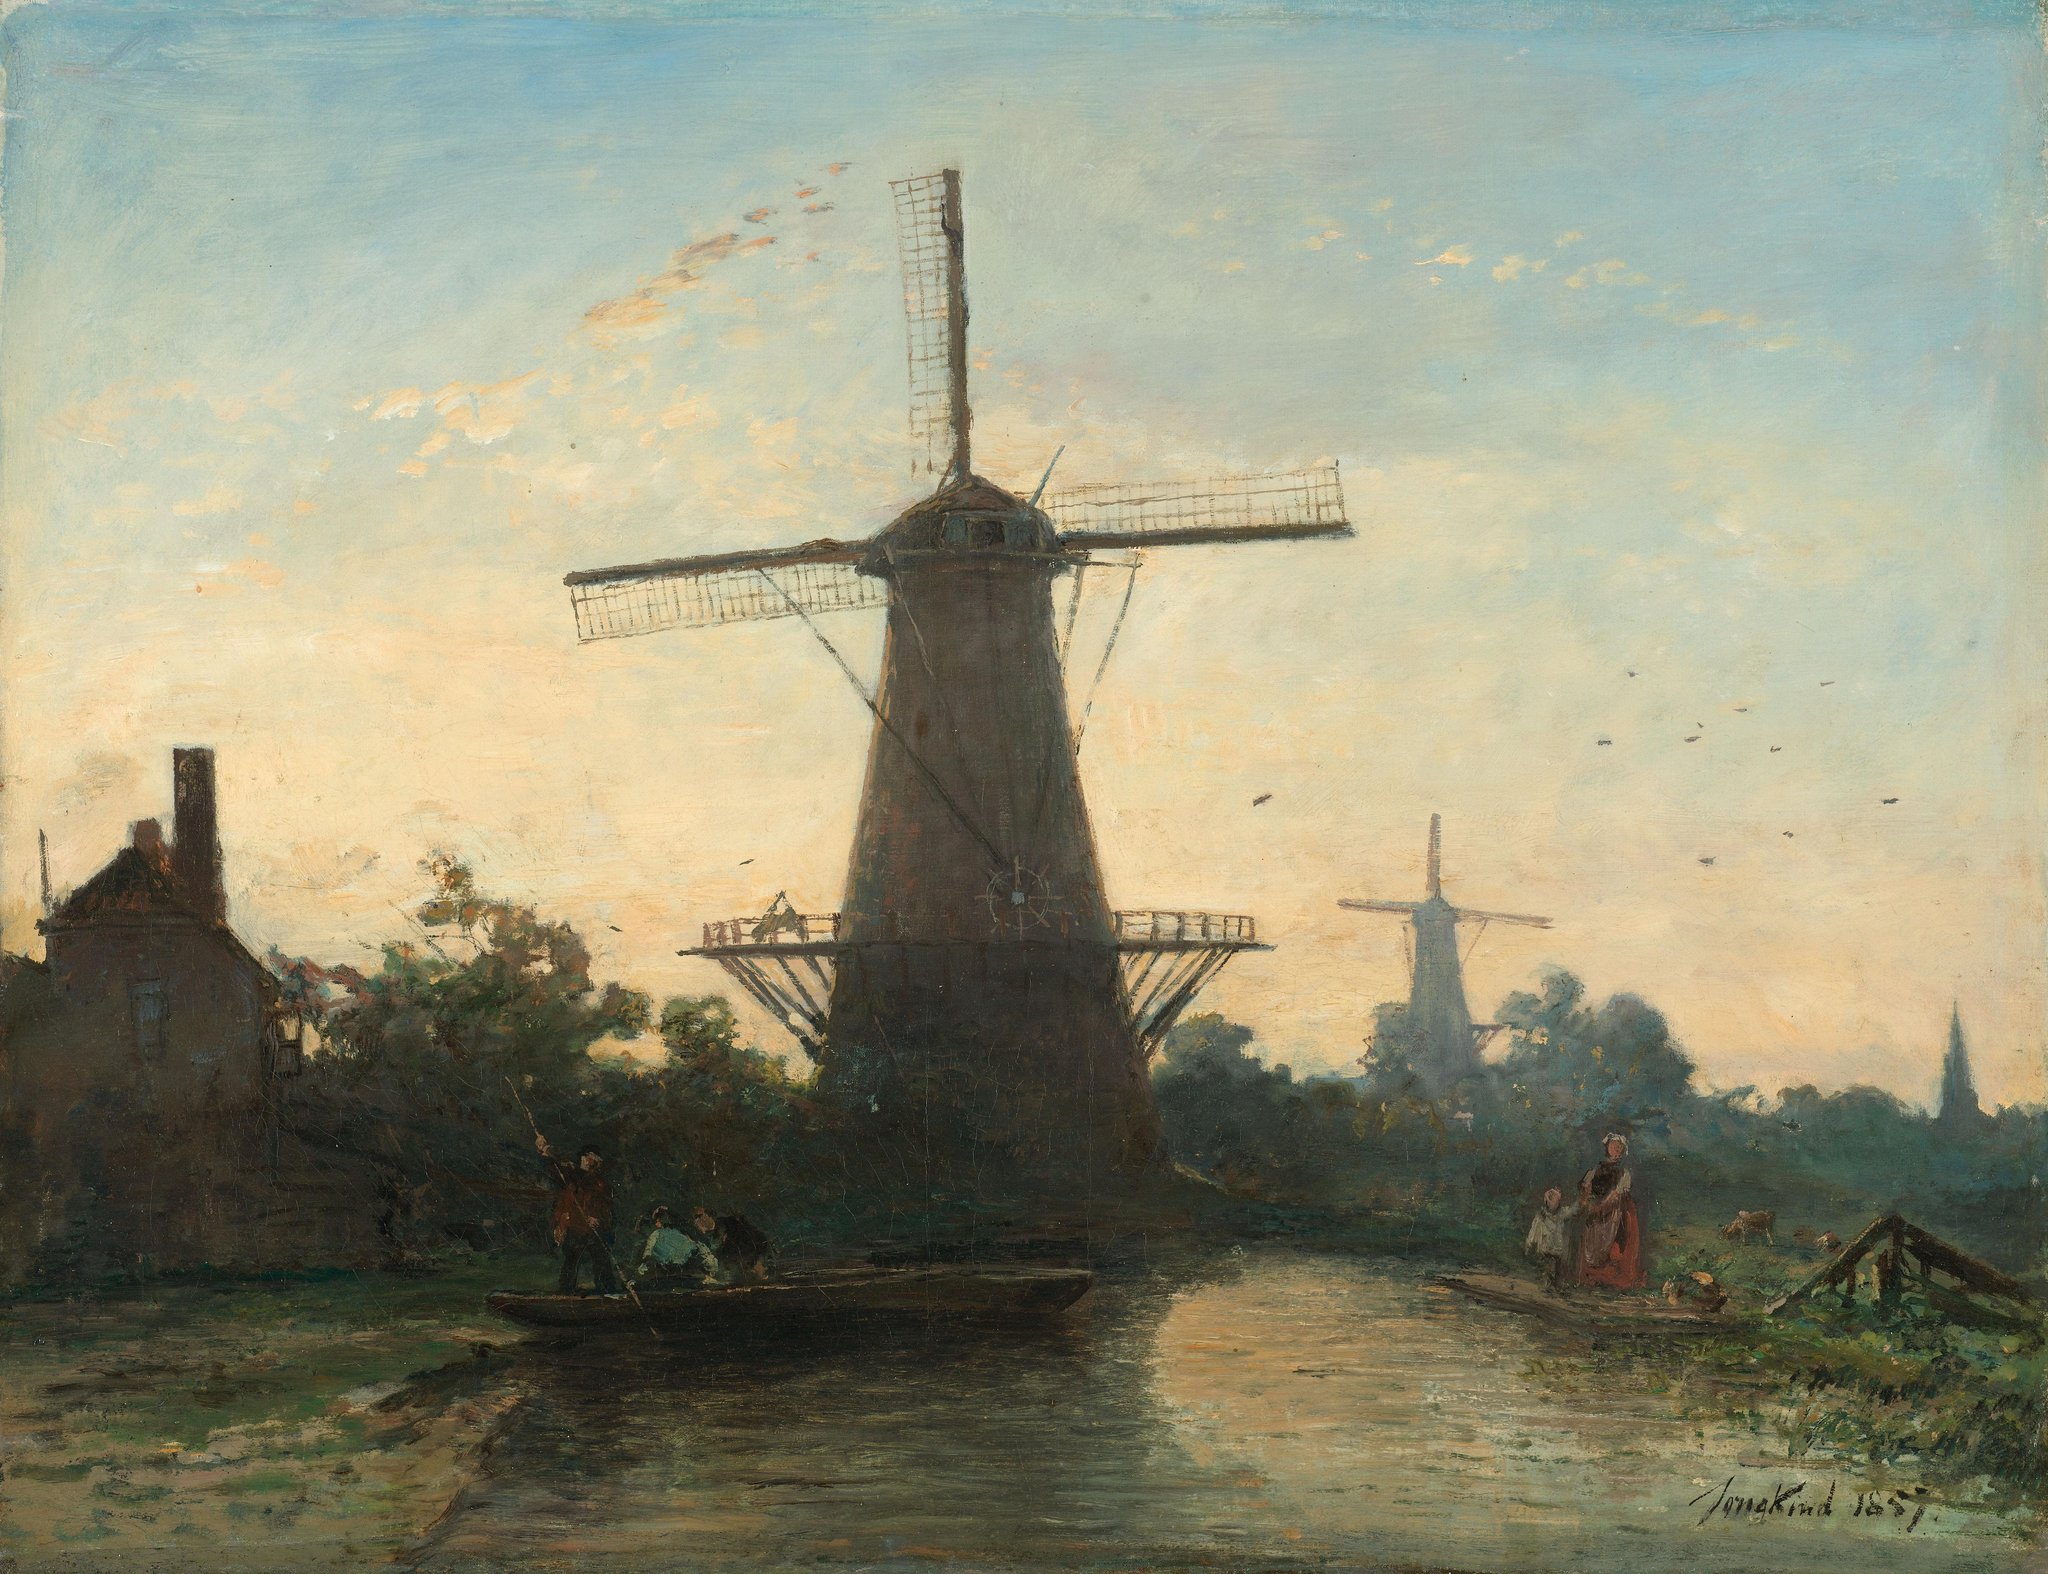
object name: painting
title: Windmills near Rotterdam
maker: johan barthold jongkind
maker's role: draughtsman, painter, print maker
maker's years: 1819-1891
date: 1857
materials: canvas, oil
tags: windmill in landscape, windmill, rotterdam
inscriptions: signature and date: ‘Jongkind 1857’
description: Twee molens aan een vaart bij Rotterdam. Op de voorgrond een veerpontje, rechts wacht een moeder met kind, links een huis.